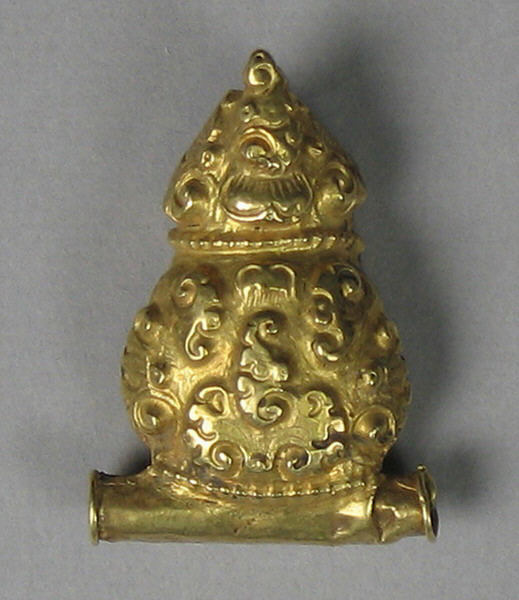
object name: pendant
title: Repoussé Tiger Claw Pendant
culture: indonesian, central java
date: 701-1200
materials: gold